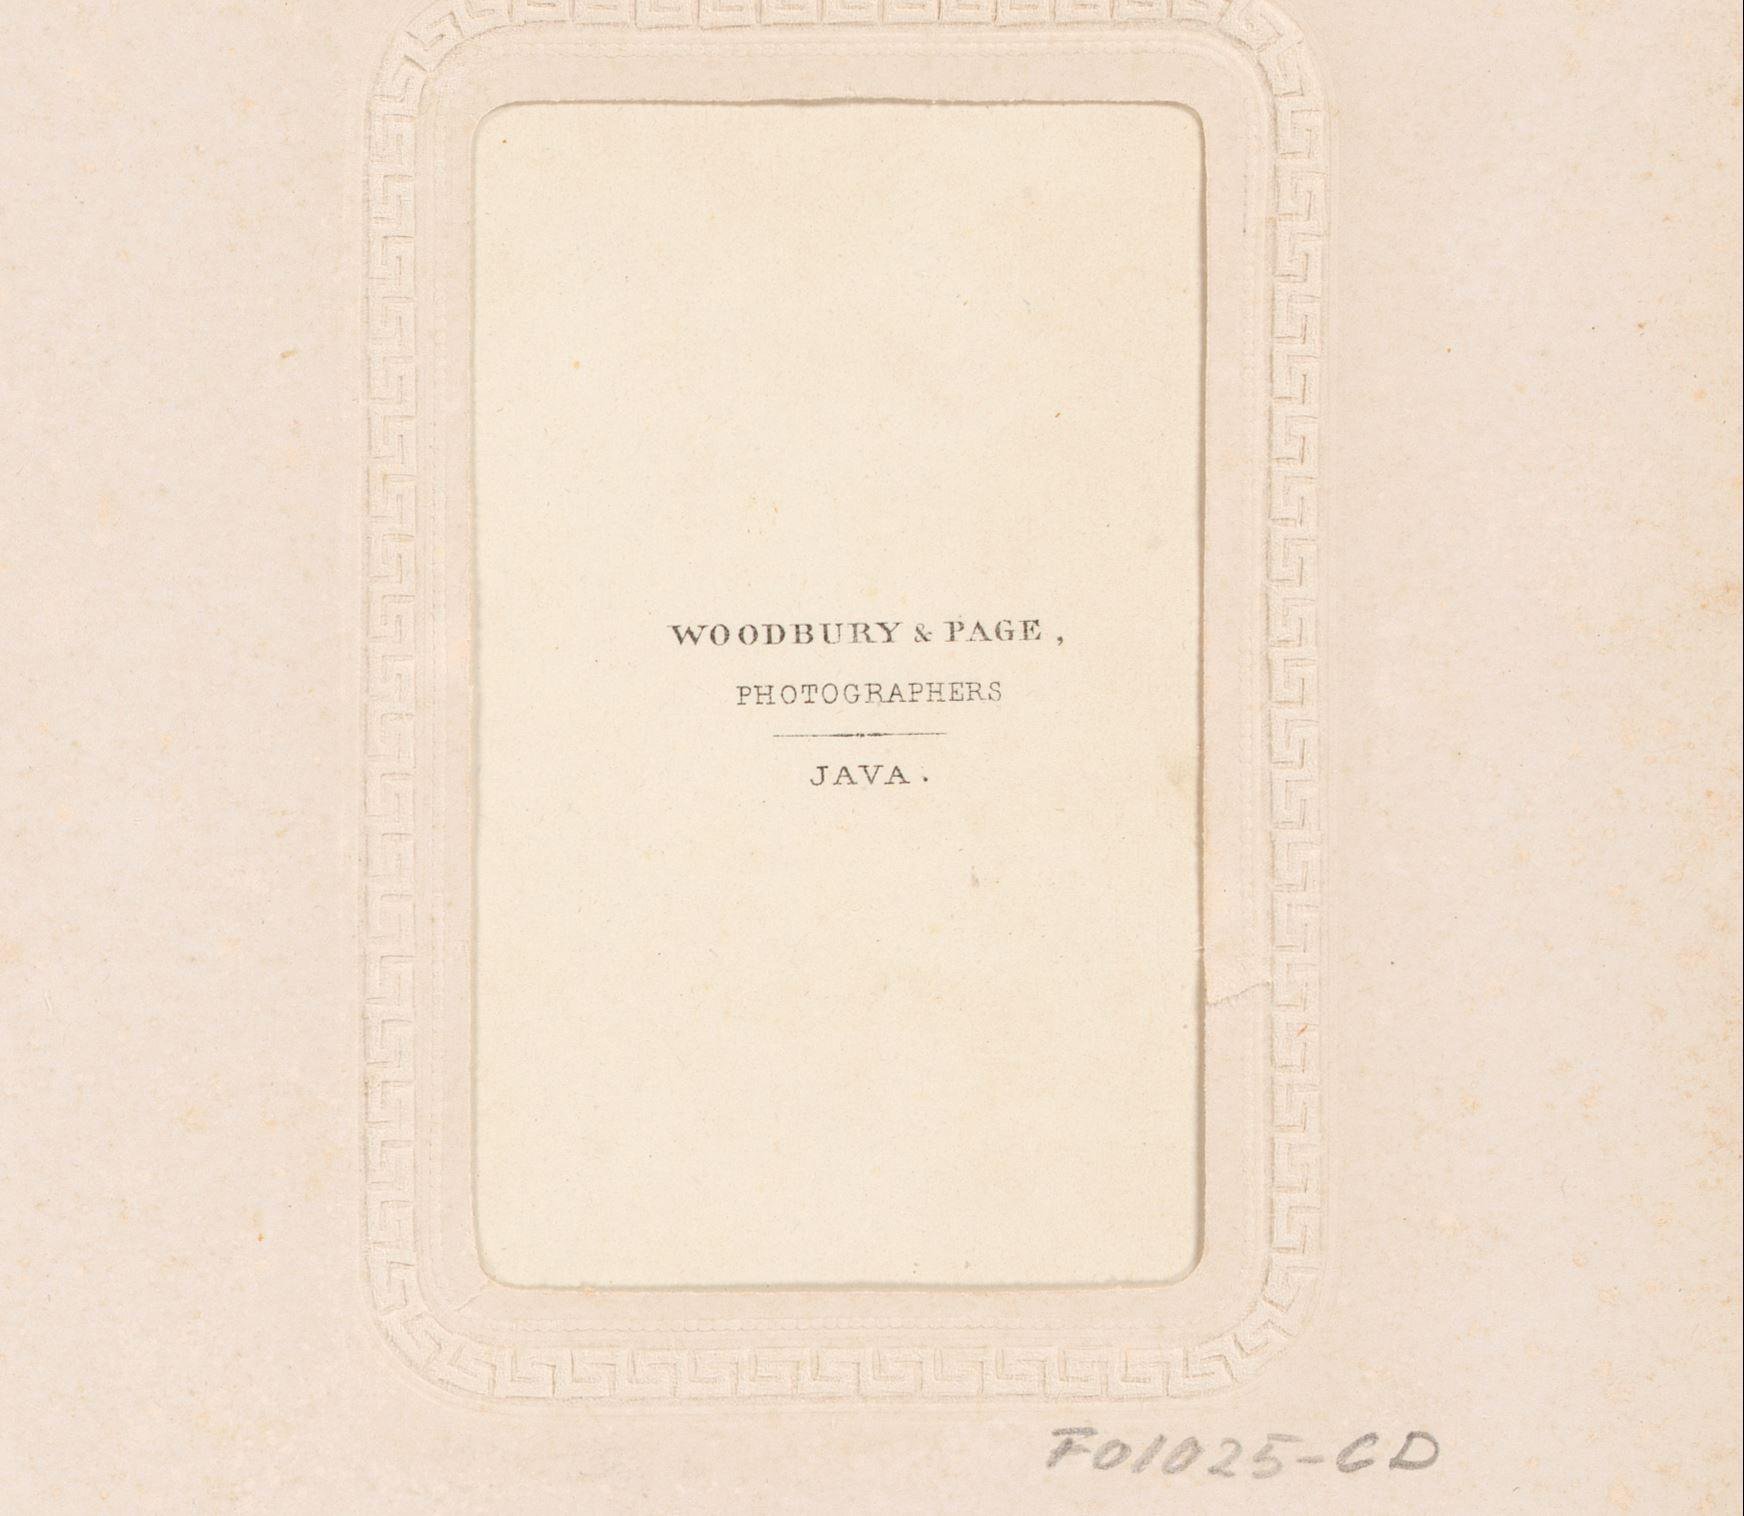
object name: photograph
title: Portret van twee Indonesische timmerlieden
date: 1857-1880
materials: cardboard, photographic support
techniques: albumen print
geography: dutch east indies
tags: carpenter, dutch east indies, the